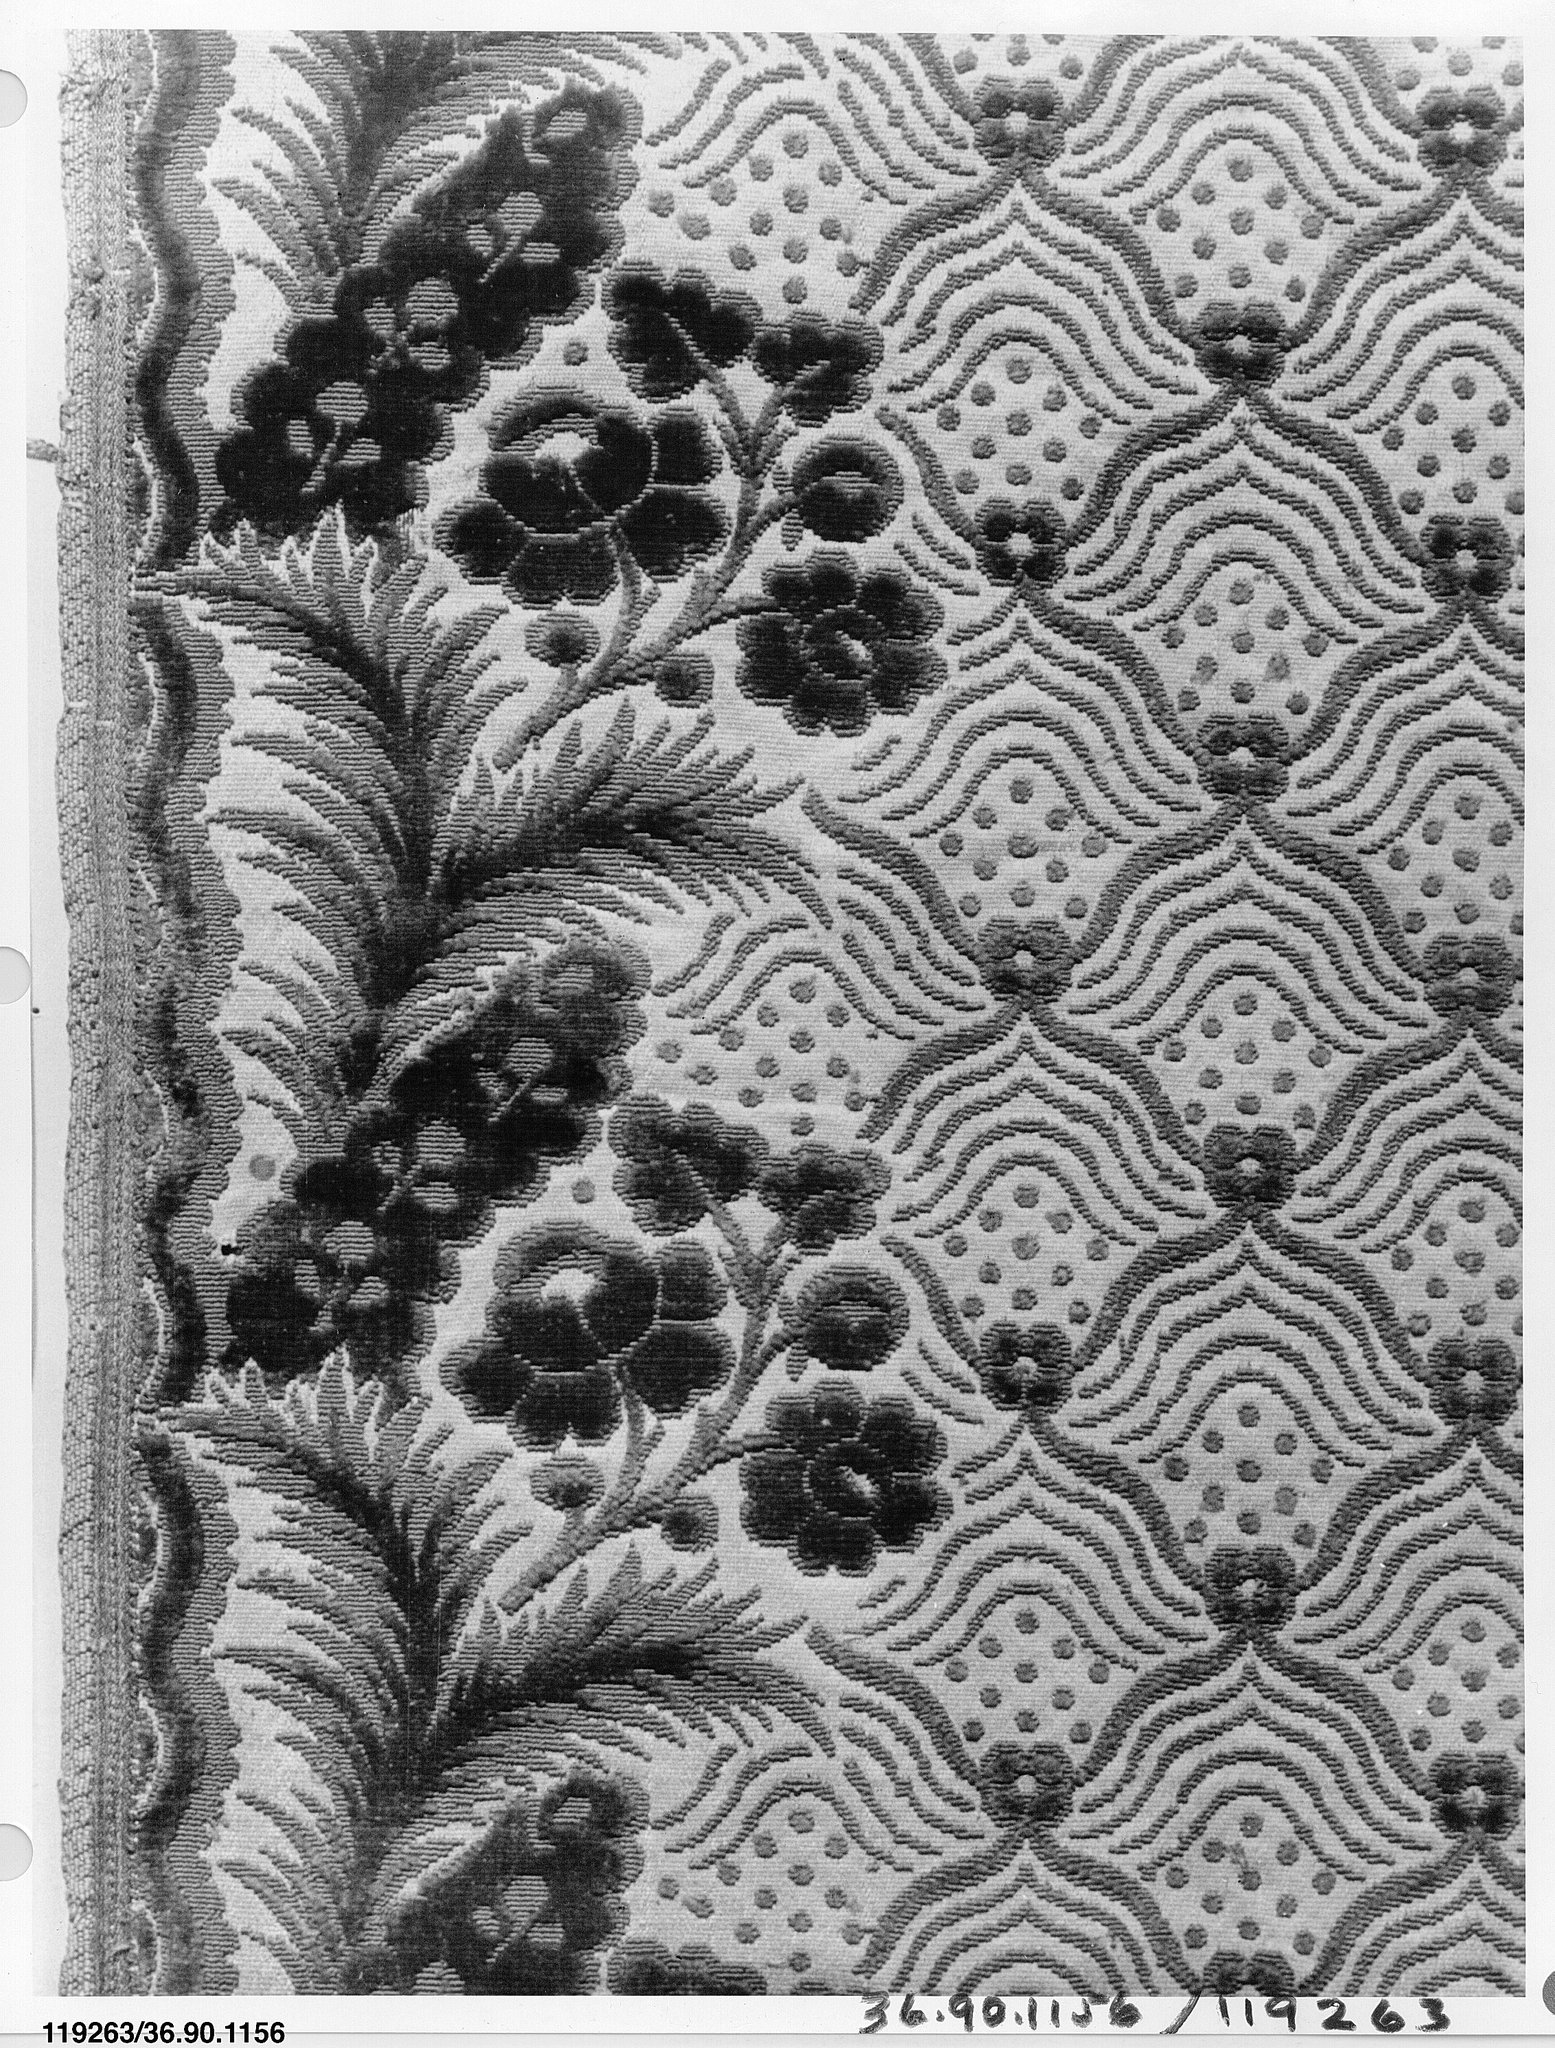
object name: piece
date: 1701-1800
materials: silk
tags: flowers,leaves